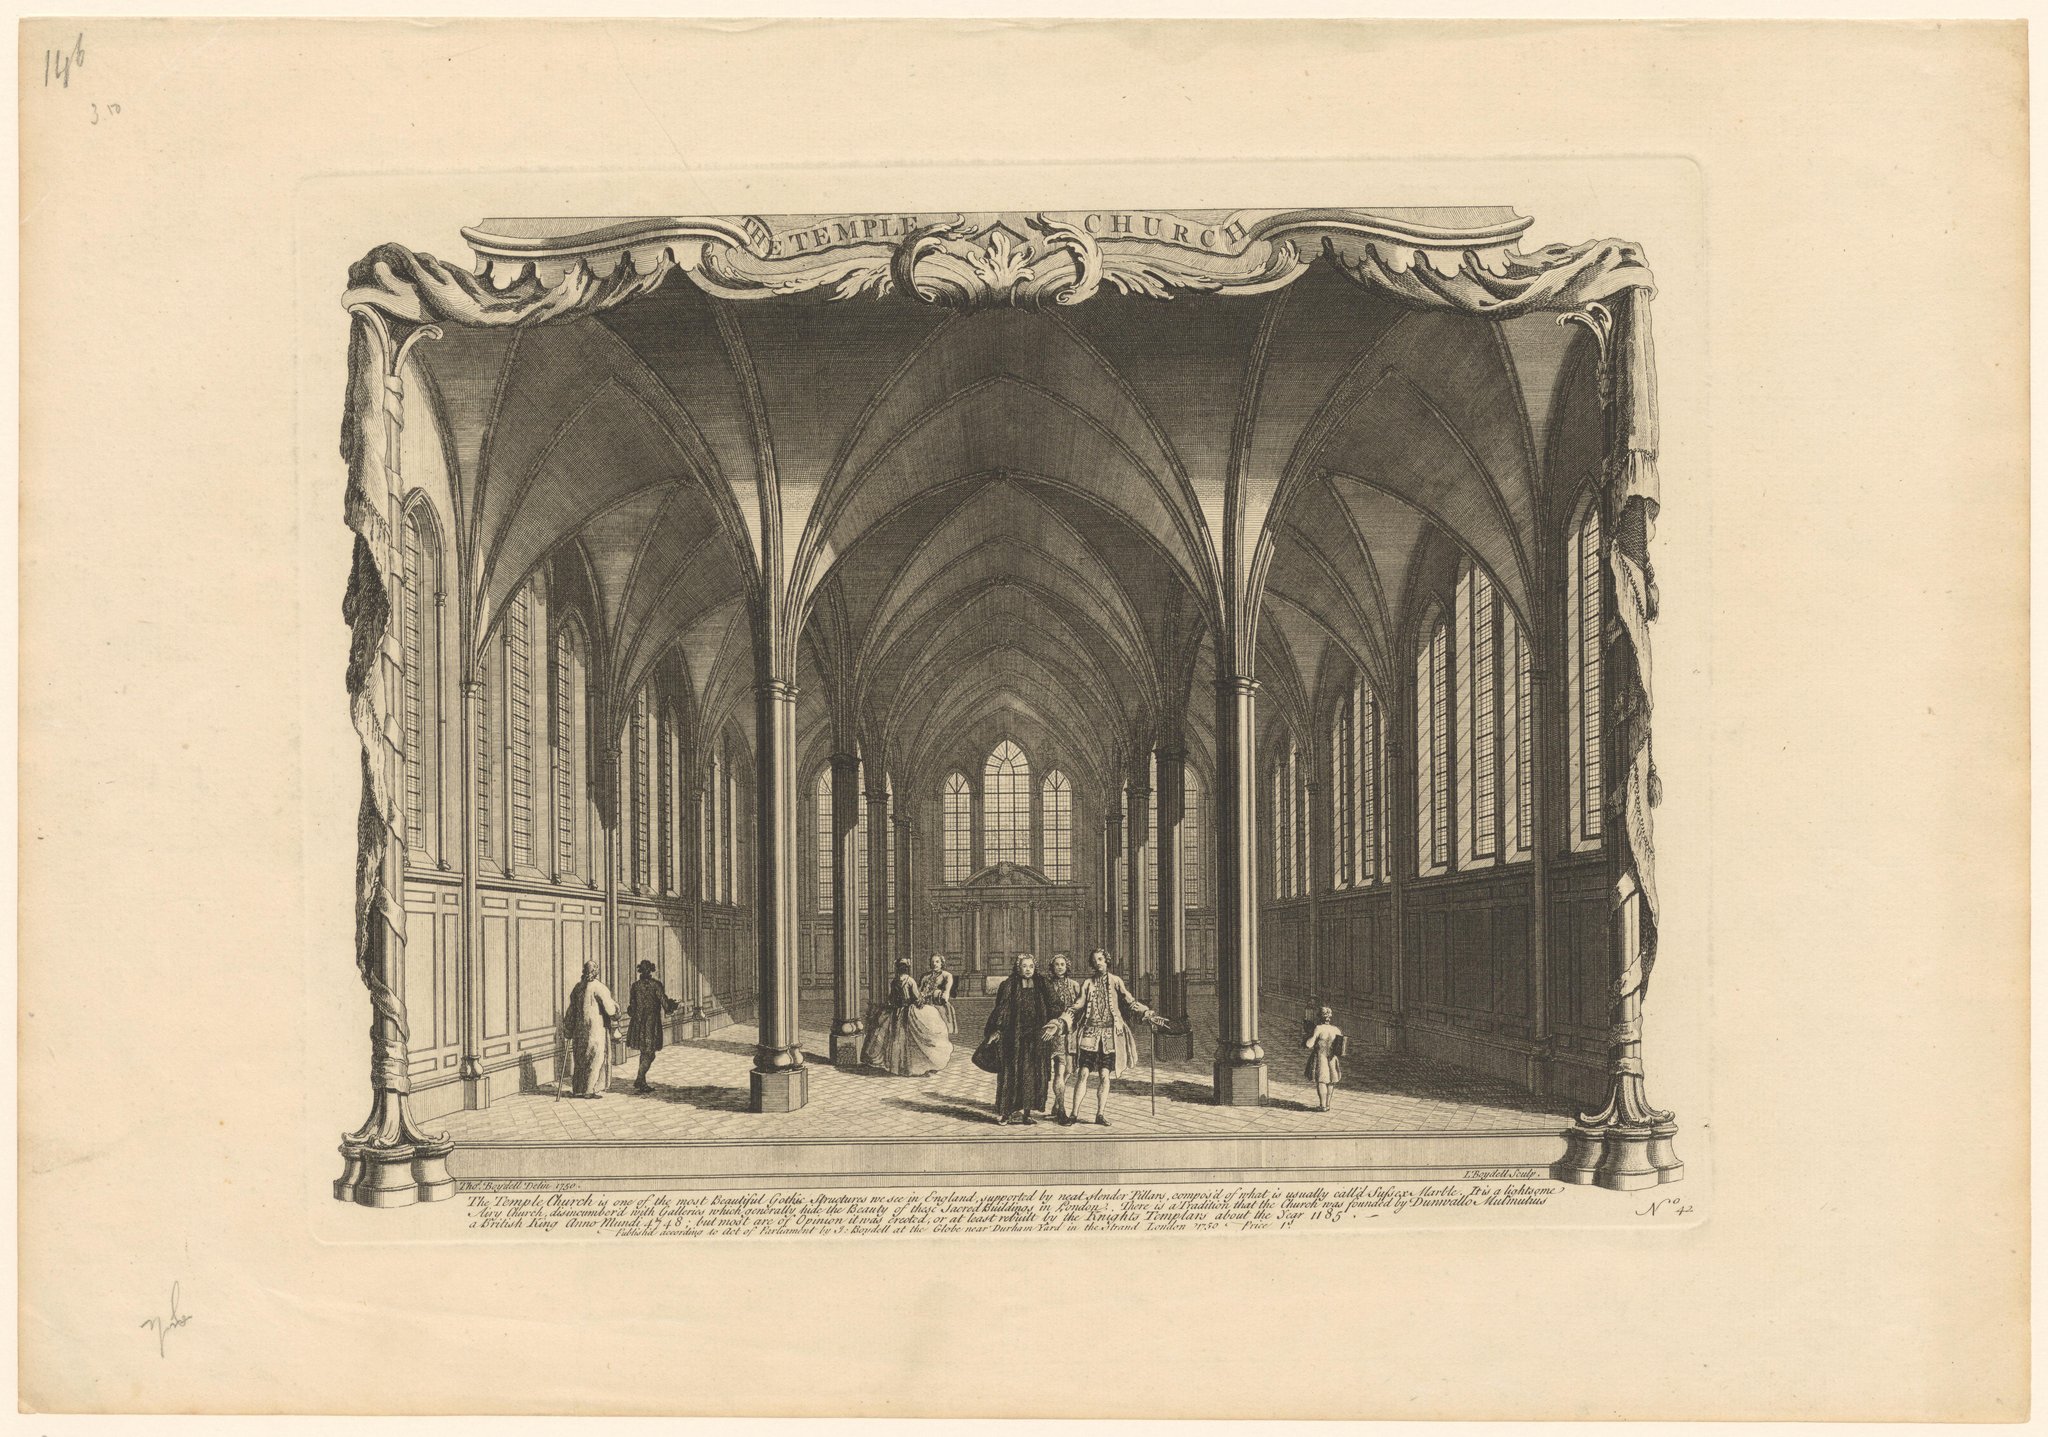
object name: print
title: Temple Church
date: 1750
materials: paper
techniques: engraving, etching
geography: london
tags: interior of church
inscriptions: collector's mark: Lugt 2228